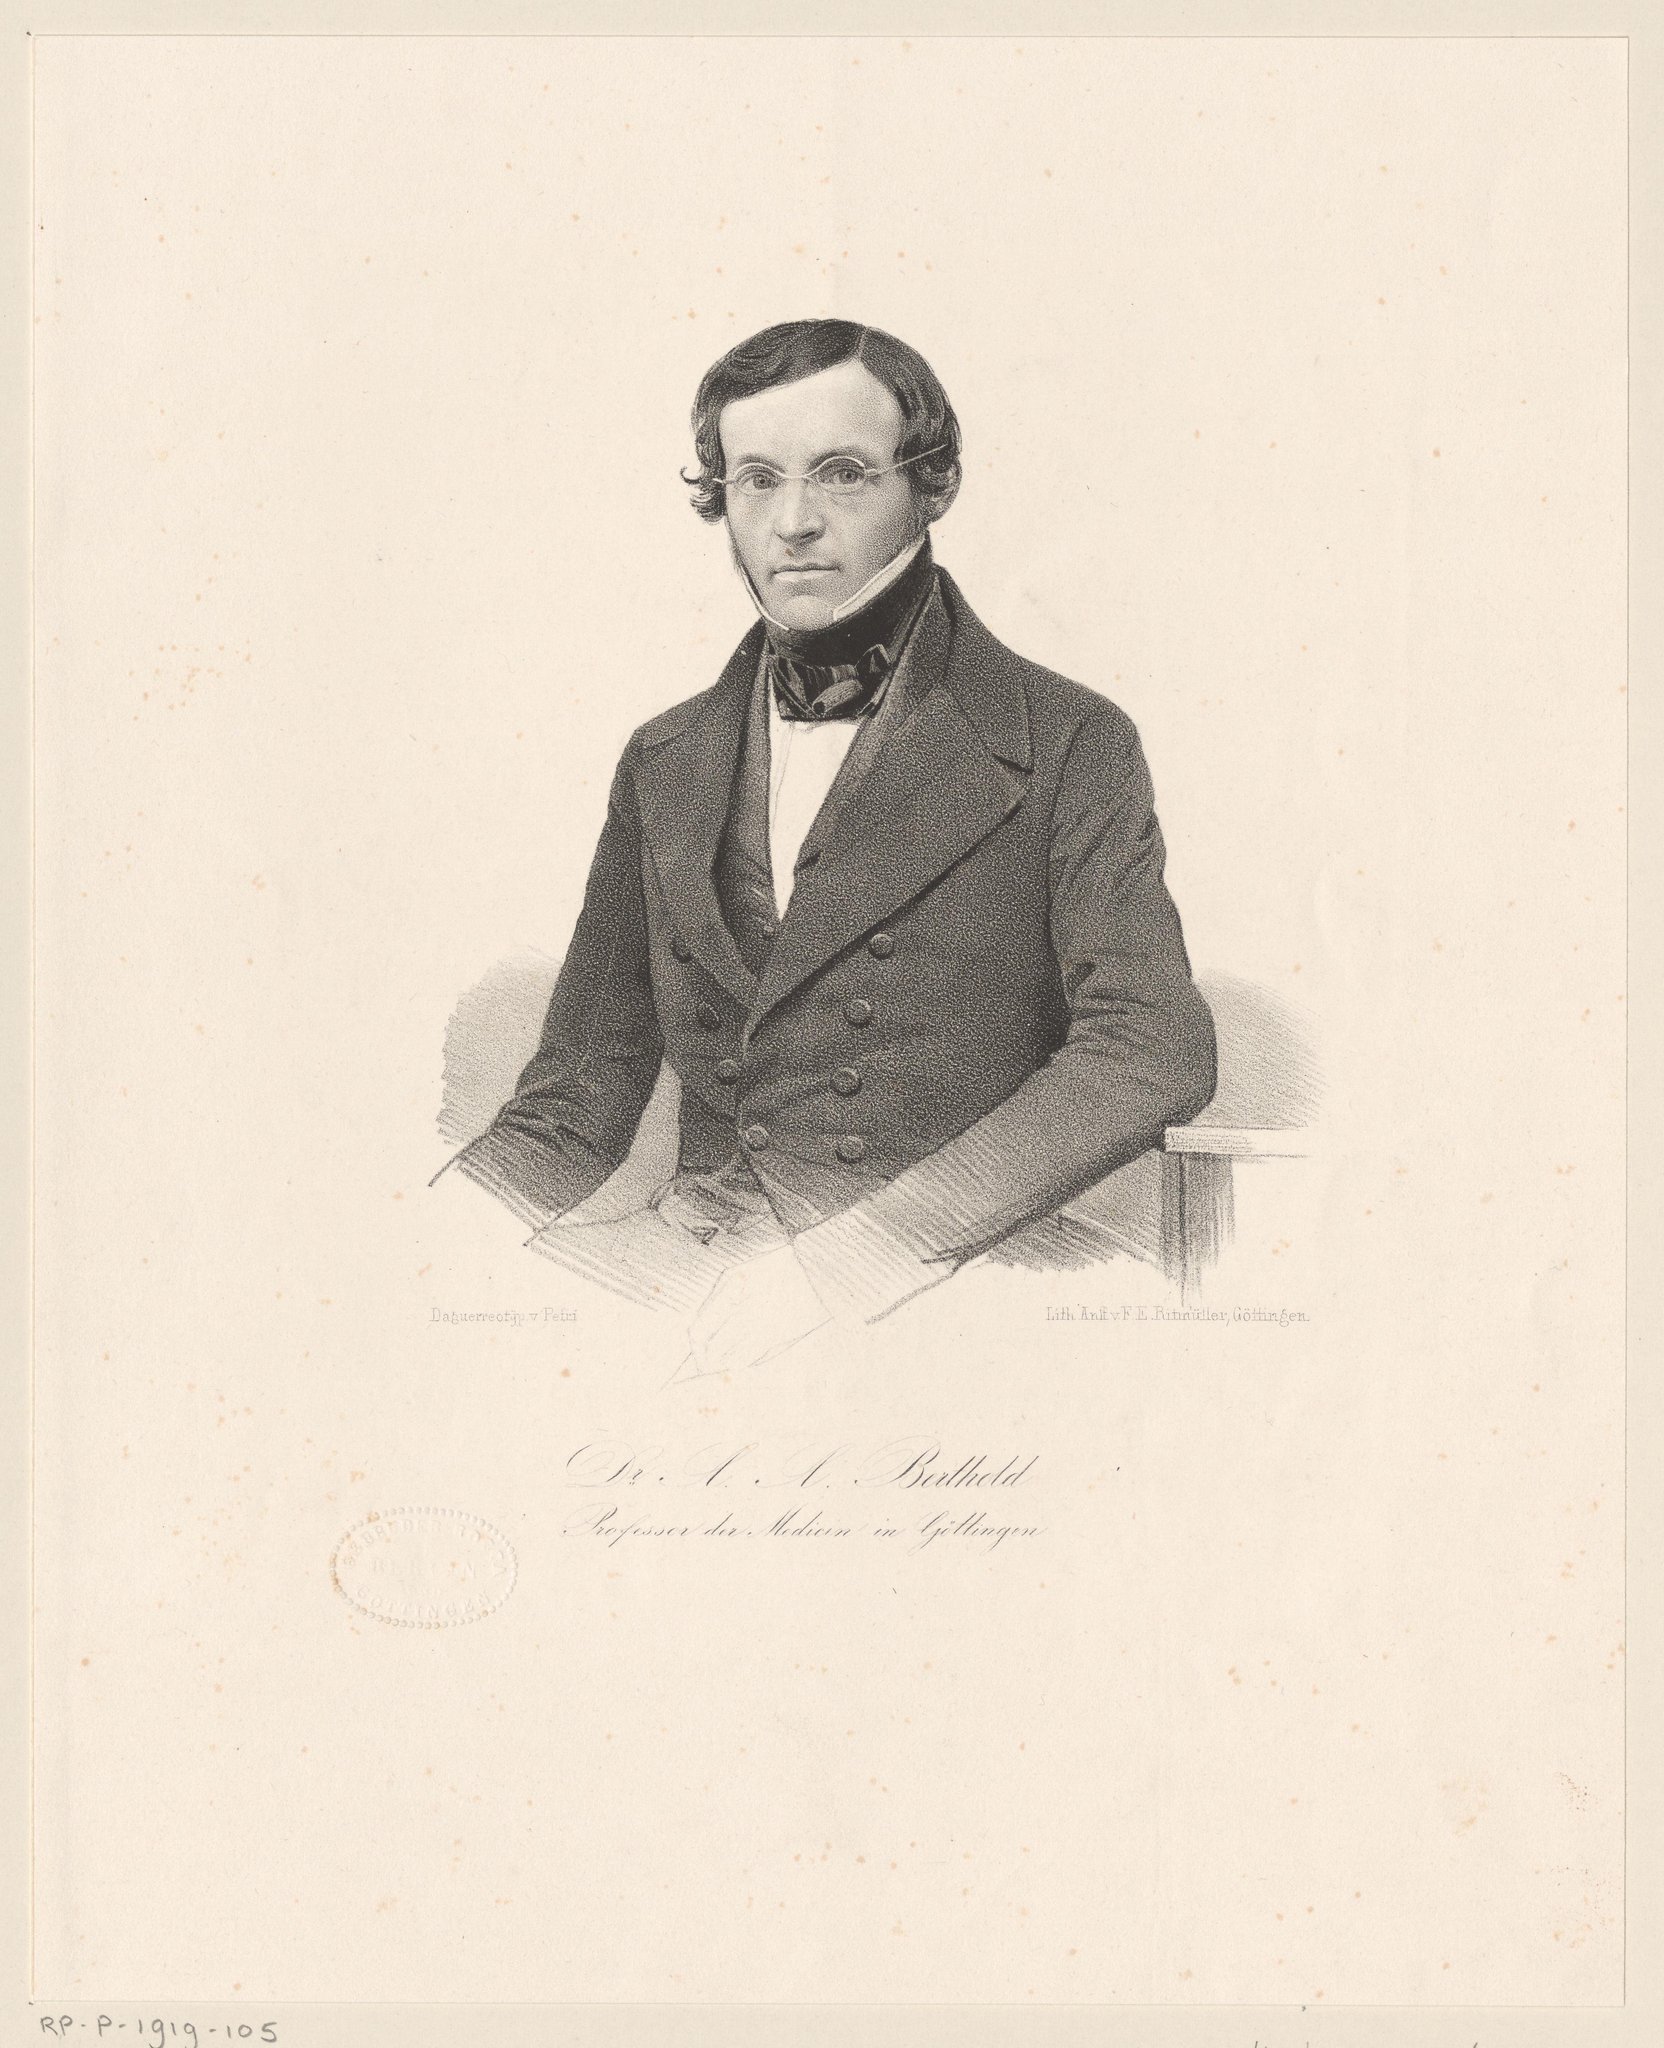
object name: print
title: Portret van Arnold Adolph Berthold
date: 1835-1875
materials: paper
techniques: lithograph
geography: gottingen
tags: eyeglasses, spectacles, historical persons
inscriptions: collector's mark: Lugt 2228, workshop stamp: Lugt 5514